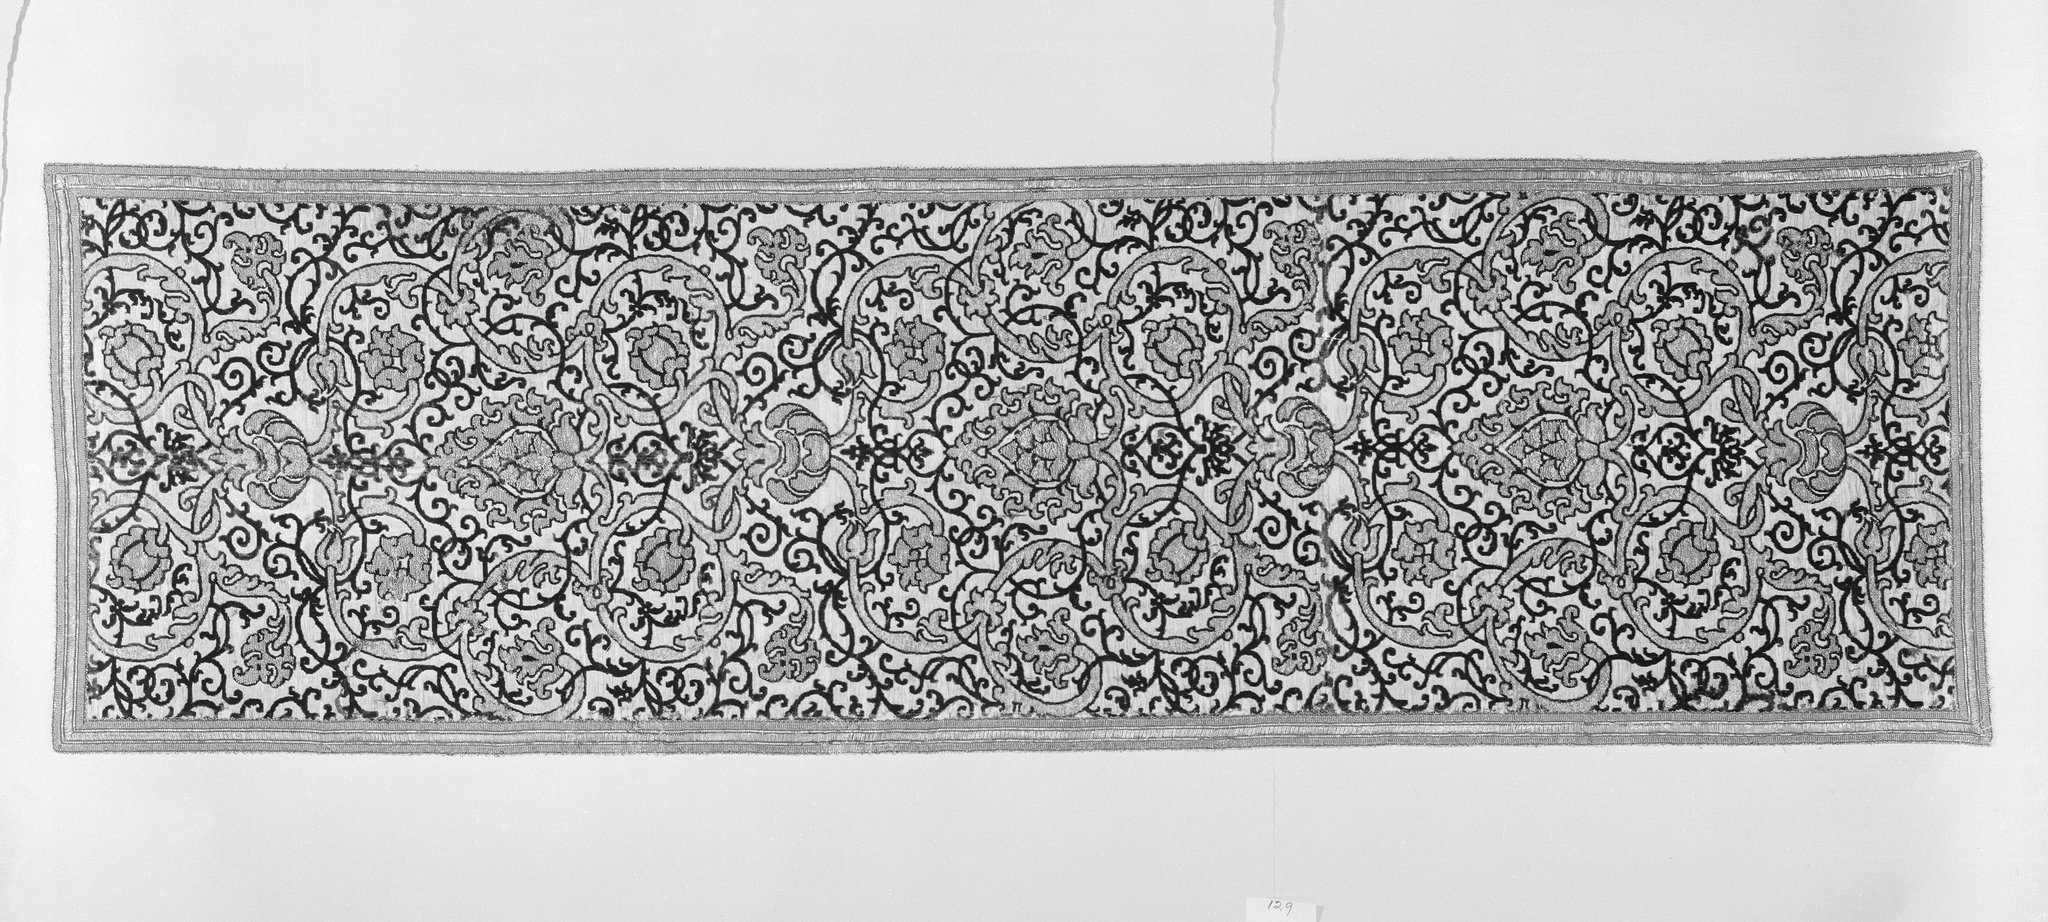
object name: length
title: Length of brocaded velvet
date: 1501-1550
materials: metal thread, silk